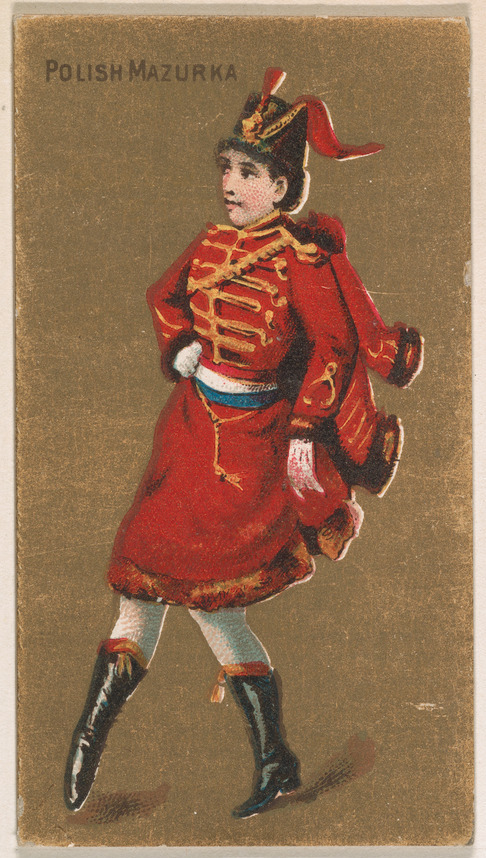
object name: print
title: Polish Mazurka, from National Dances (N225, Type 2) issued by Kinney Bros.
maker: kinney brothers tobacco company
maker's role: publisher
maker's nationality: american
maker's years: 1869-2011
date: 1889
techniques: color lithograph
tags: men,dancing,dancers